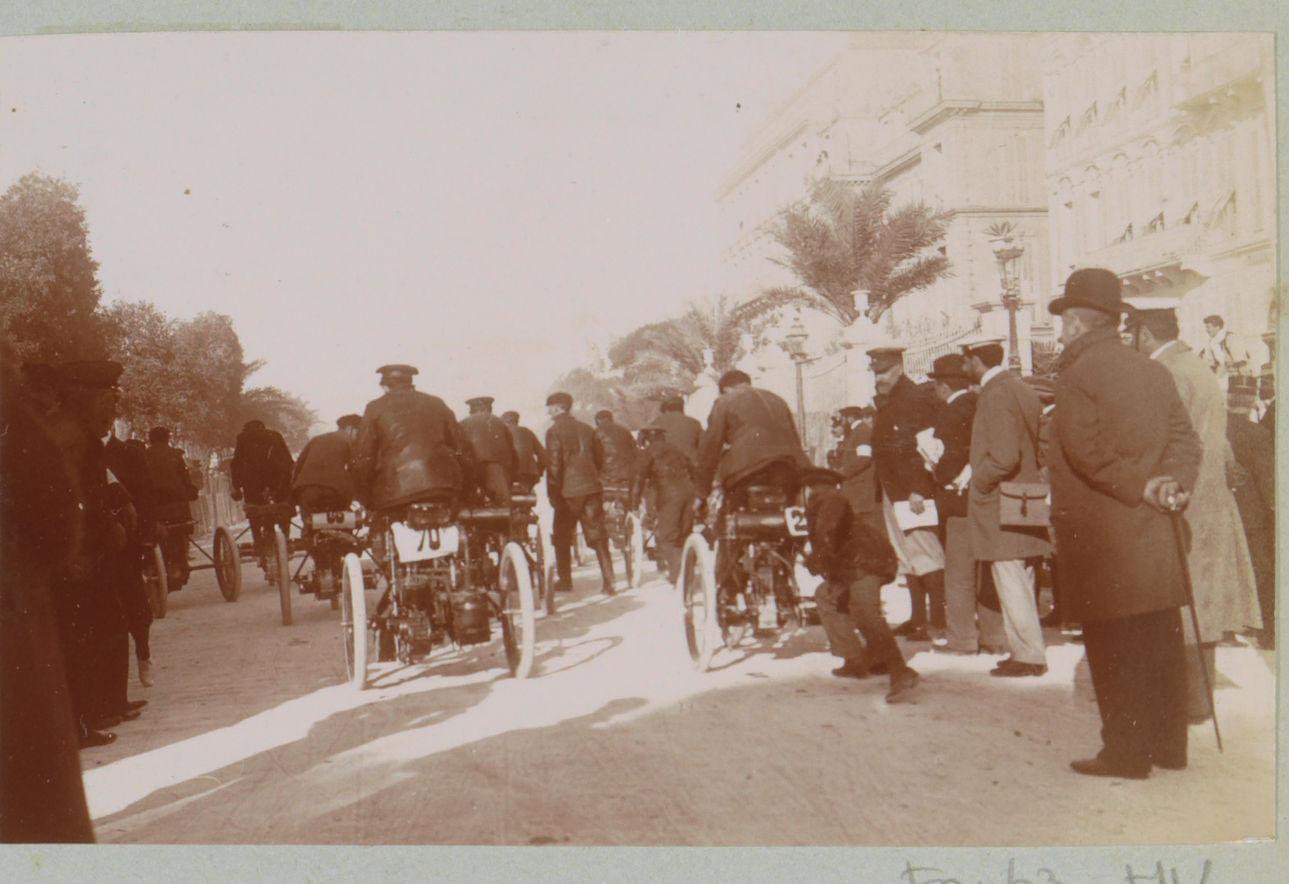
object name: photograph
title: Gemotoriseerde driewielers bij de start van de race Nice-Magagnosc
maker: delizy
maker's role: manufacturer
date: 1899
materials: paper, photographic support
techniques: gelatin silver print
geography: nice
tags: motor-cycles and other two-wheeled motor-vehicles, motorcar racing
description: Onderdeel van Fotoalbum van een Franse amateurfotograaf met opnames van uitstapjes in Frankrijk, Spanje, België, Luxemburg en Nederland, de eerste automobielen en autoraces.